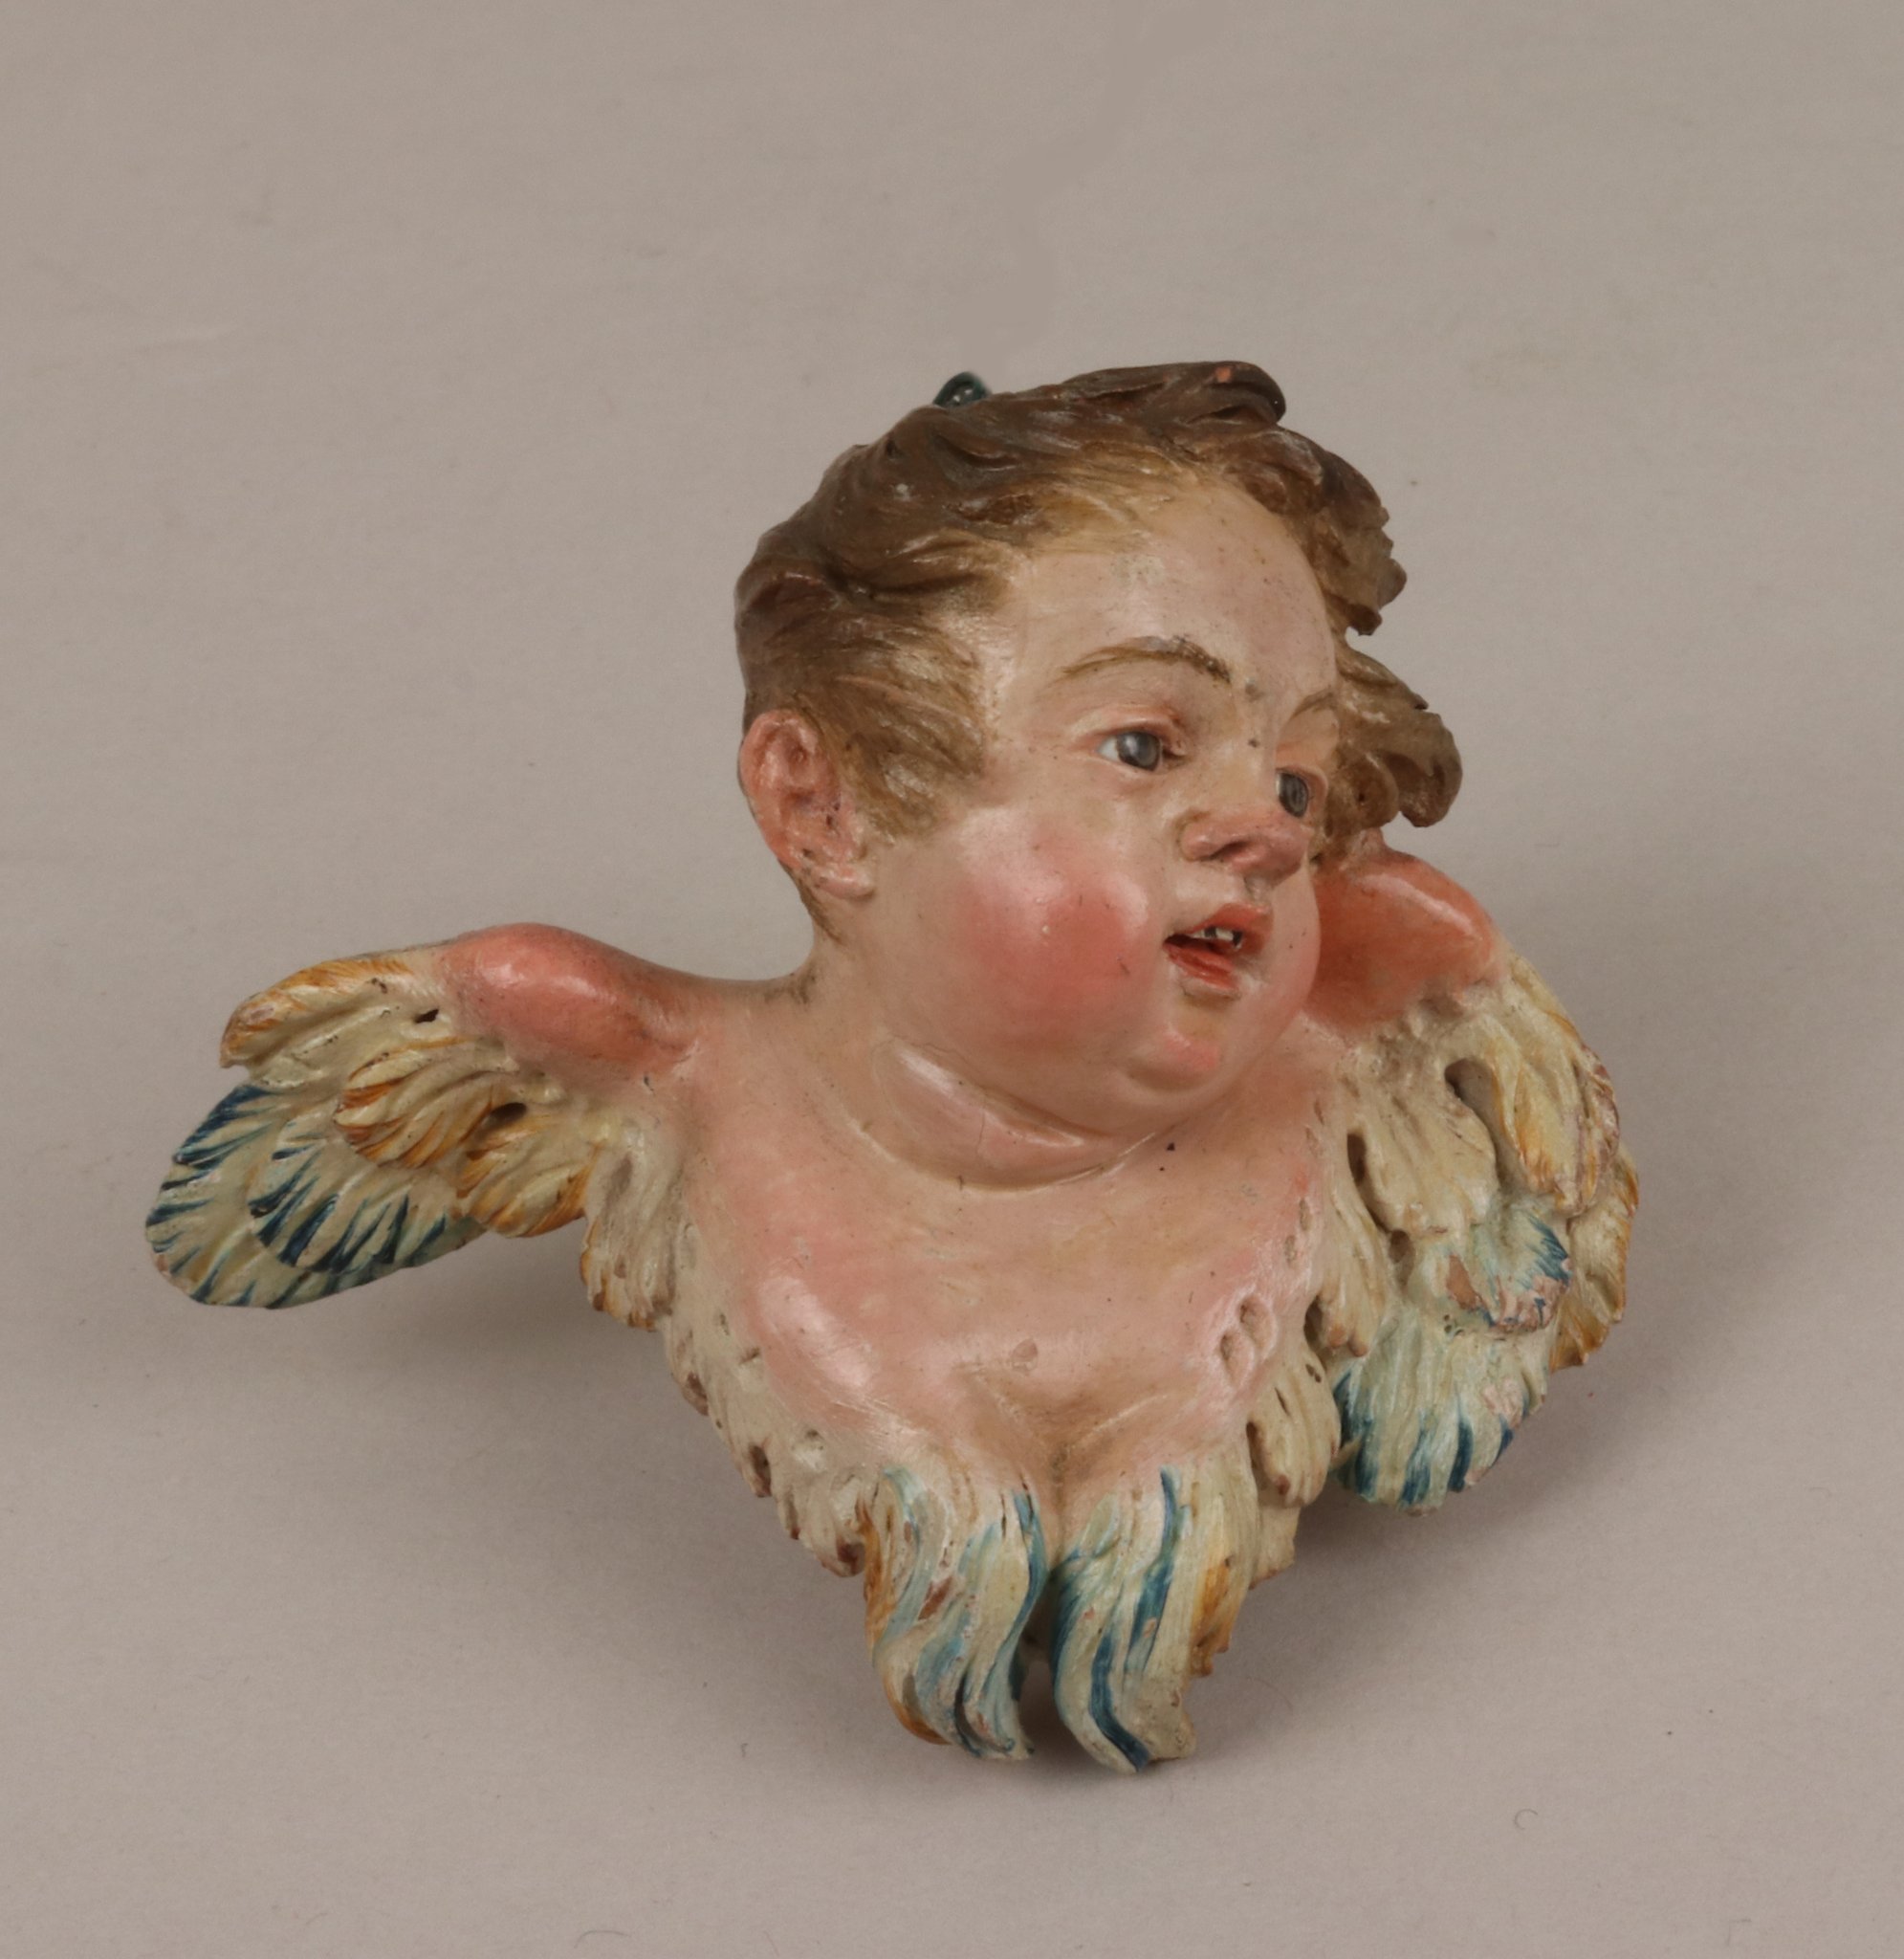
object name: crèche figure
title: Putto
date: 1701-1800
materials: terracotta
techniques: polychrome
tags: putti